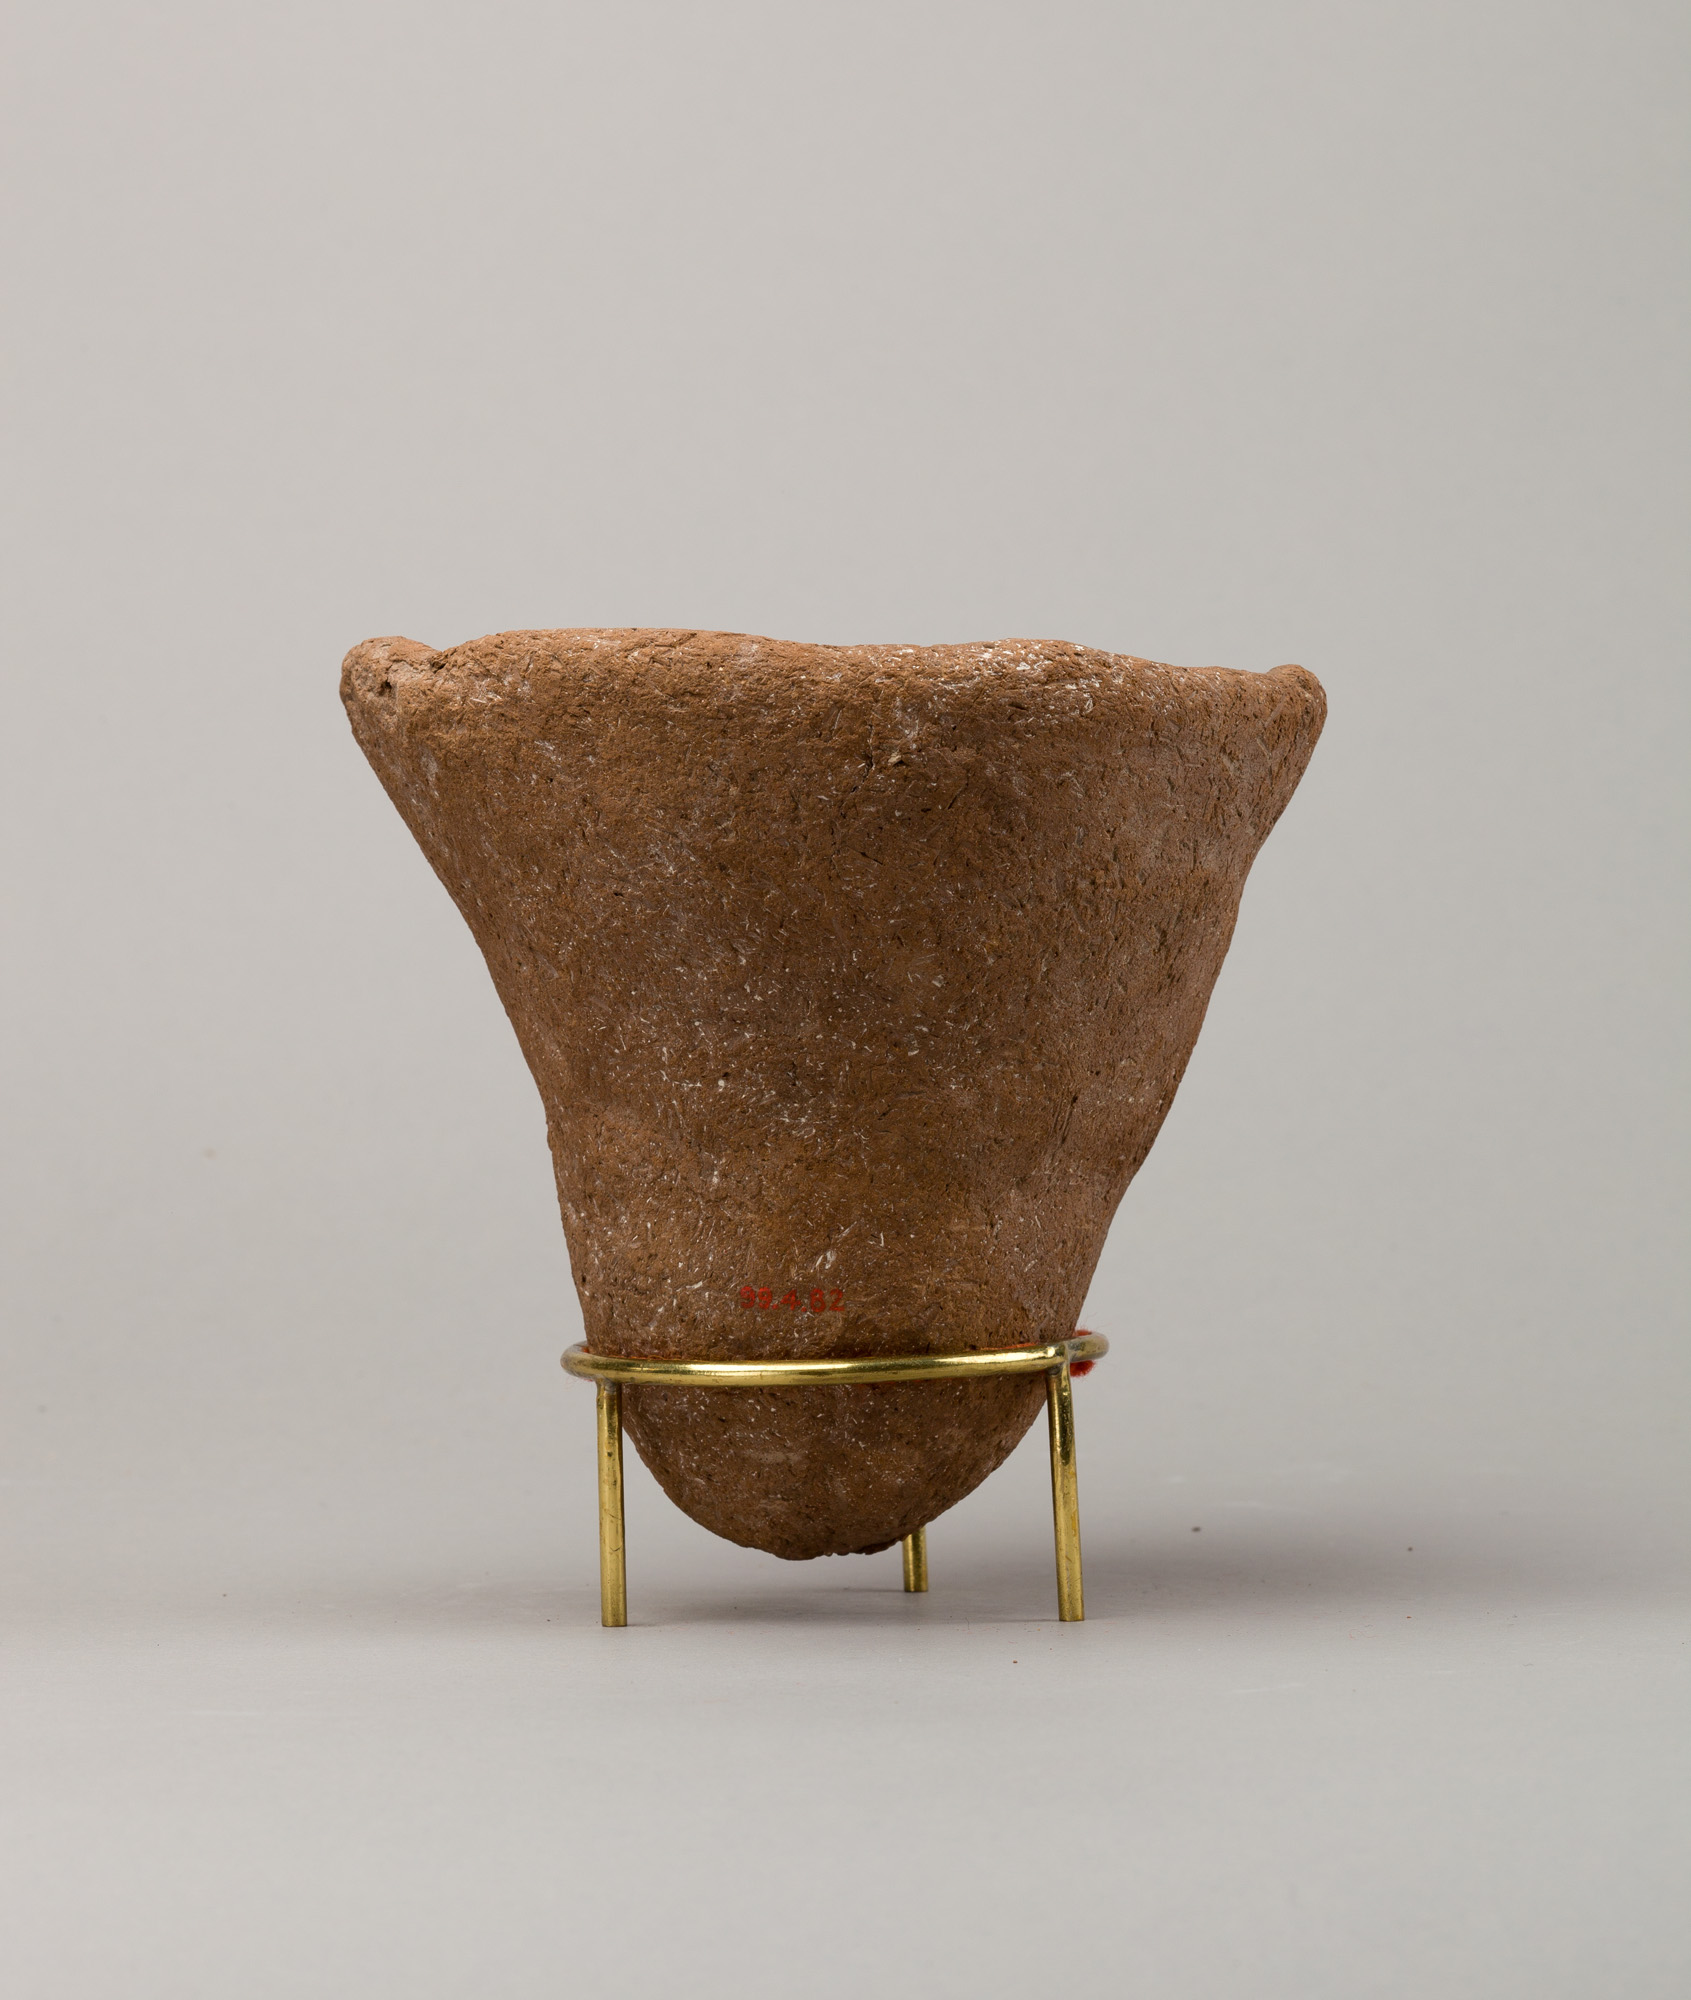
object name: jar, rough ware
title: Large rough ware jar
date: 4500-4000 BCE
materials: pottery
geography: egypt